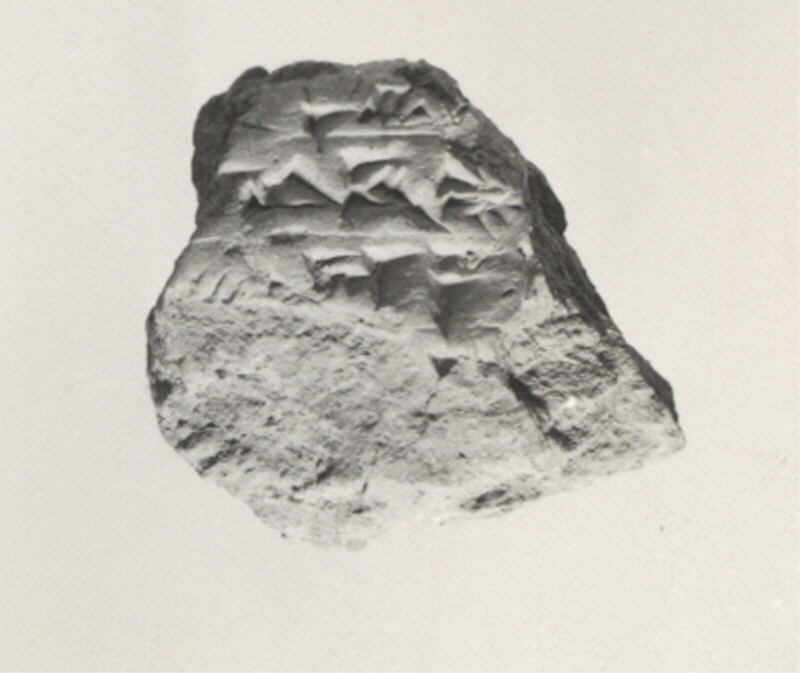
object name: cuneiform tablet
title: Cuneiform tablet: unidentified fragment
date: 333-1 BCE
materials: clay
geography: mesopotamia